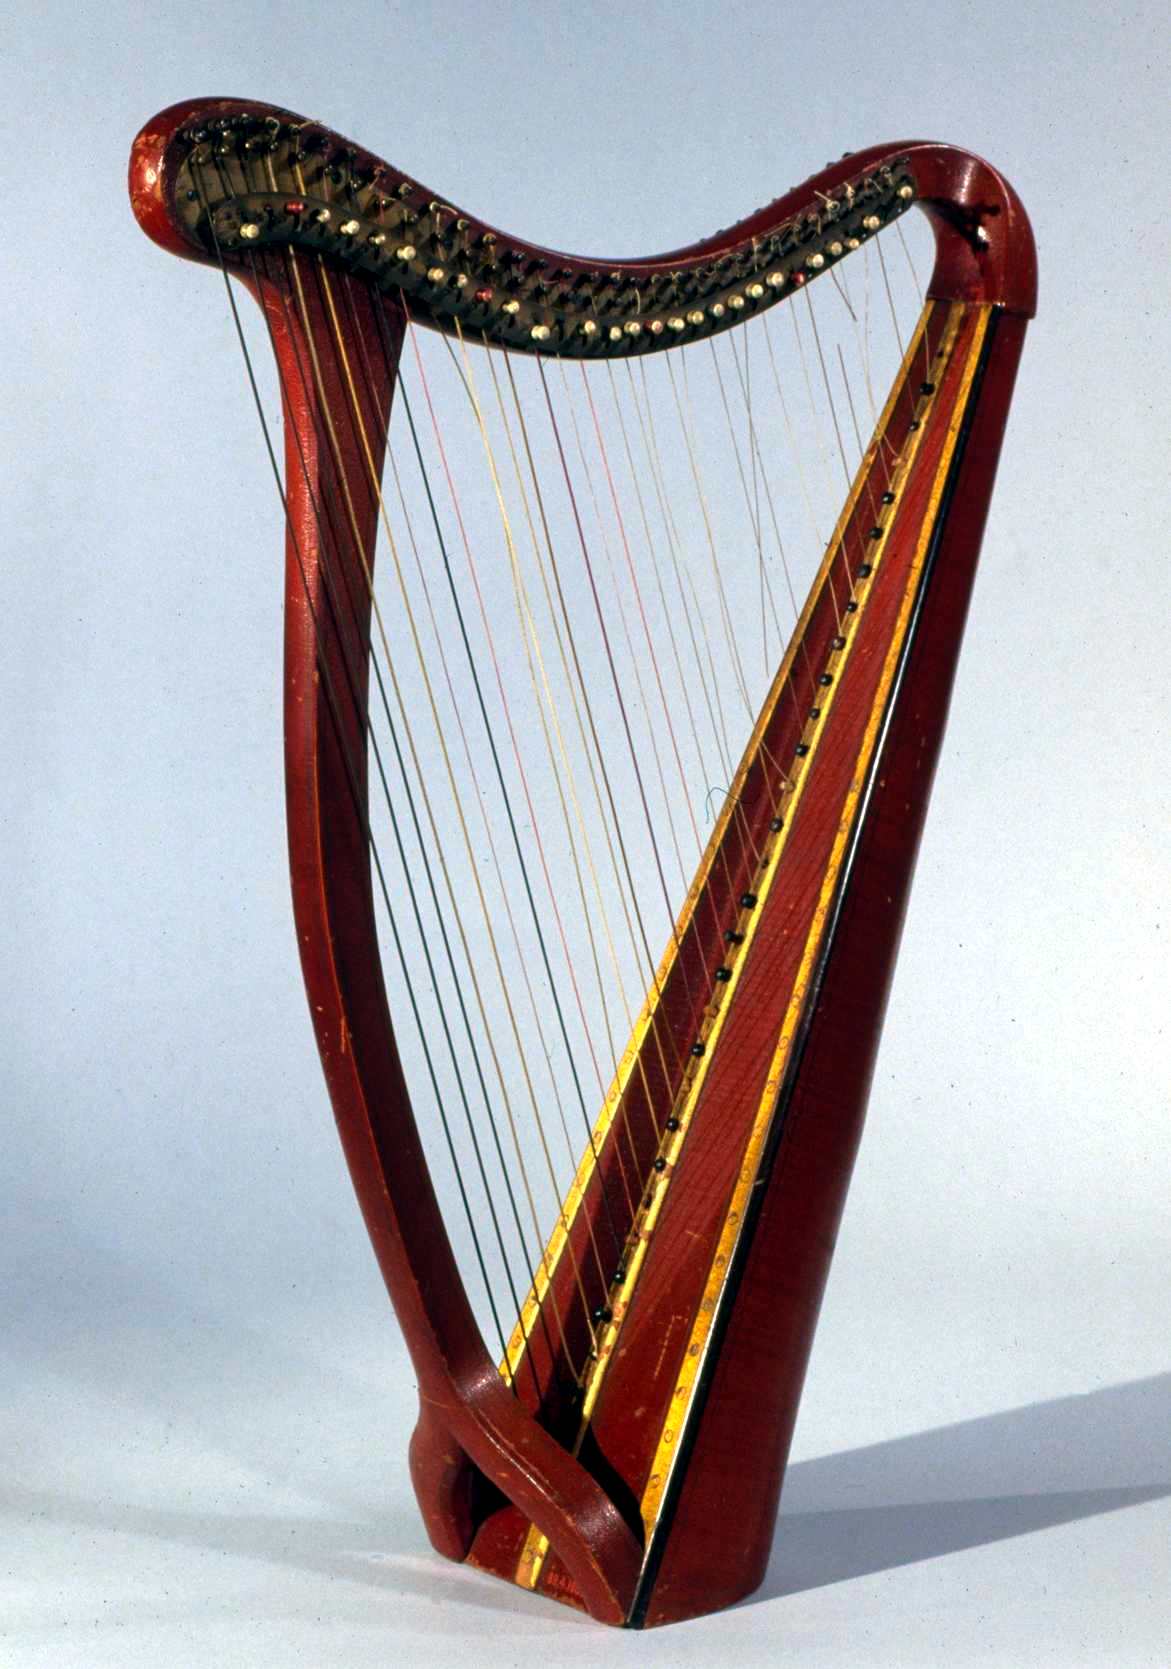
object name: portable harp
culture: french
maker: louis joseph domeny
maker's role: maker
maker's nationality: french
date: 1814-1830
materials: wood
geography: france